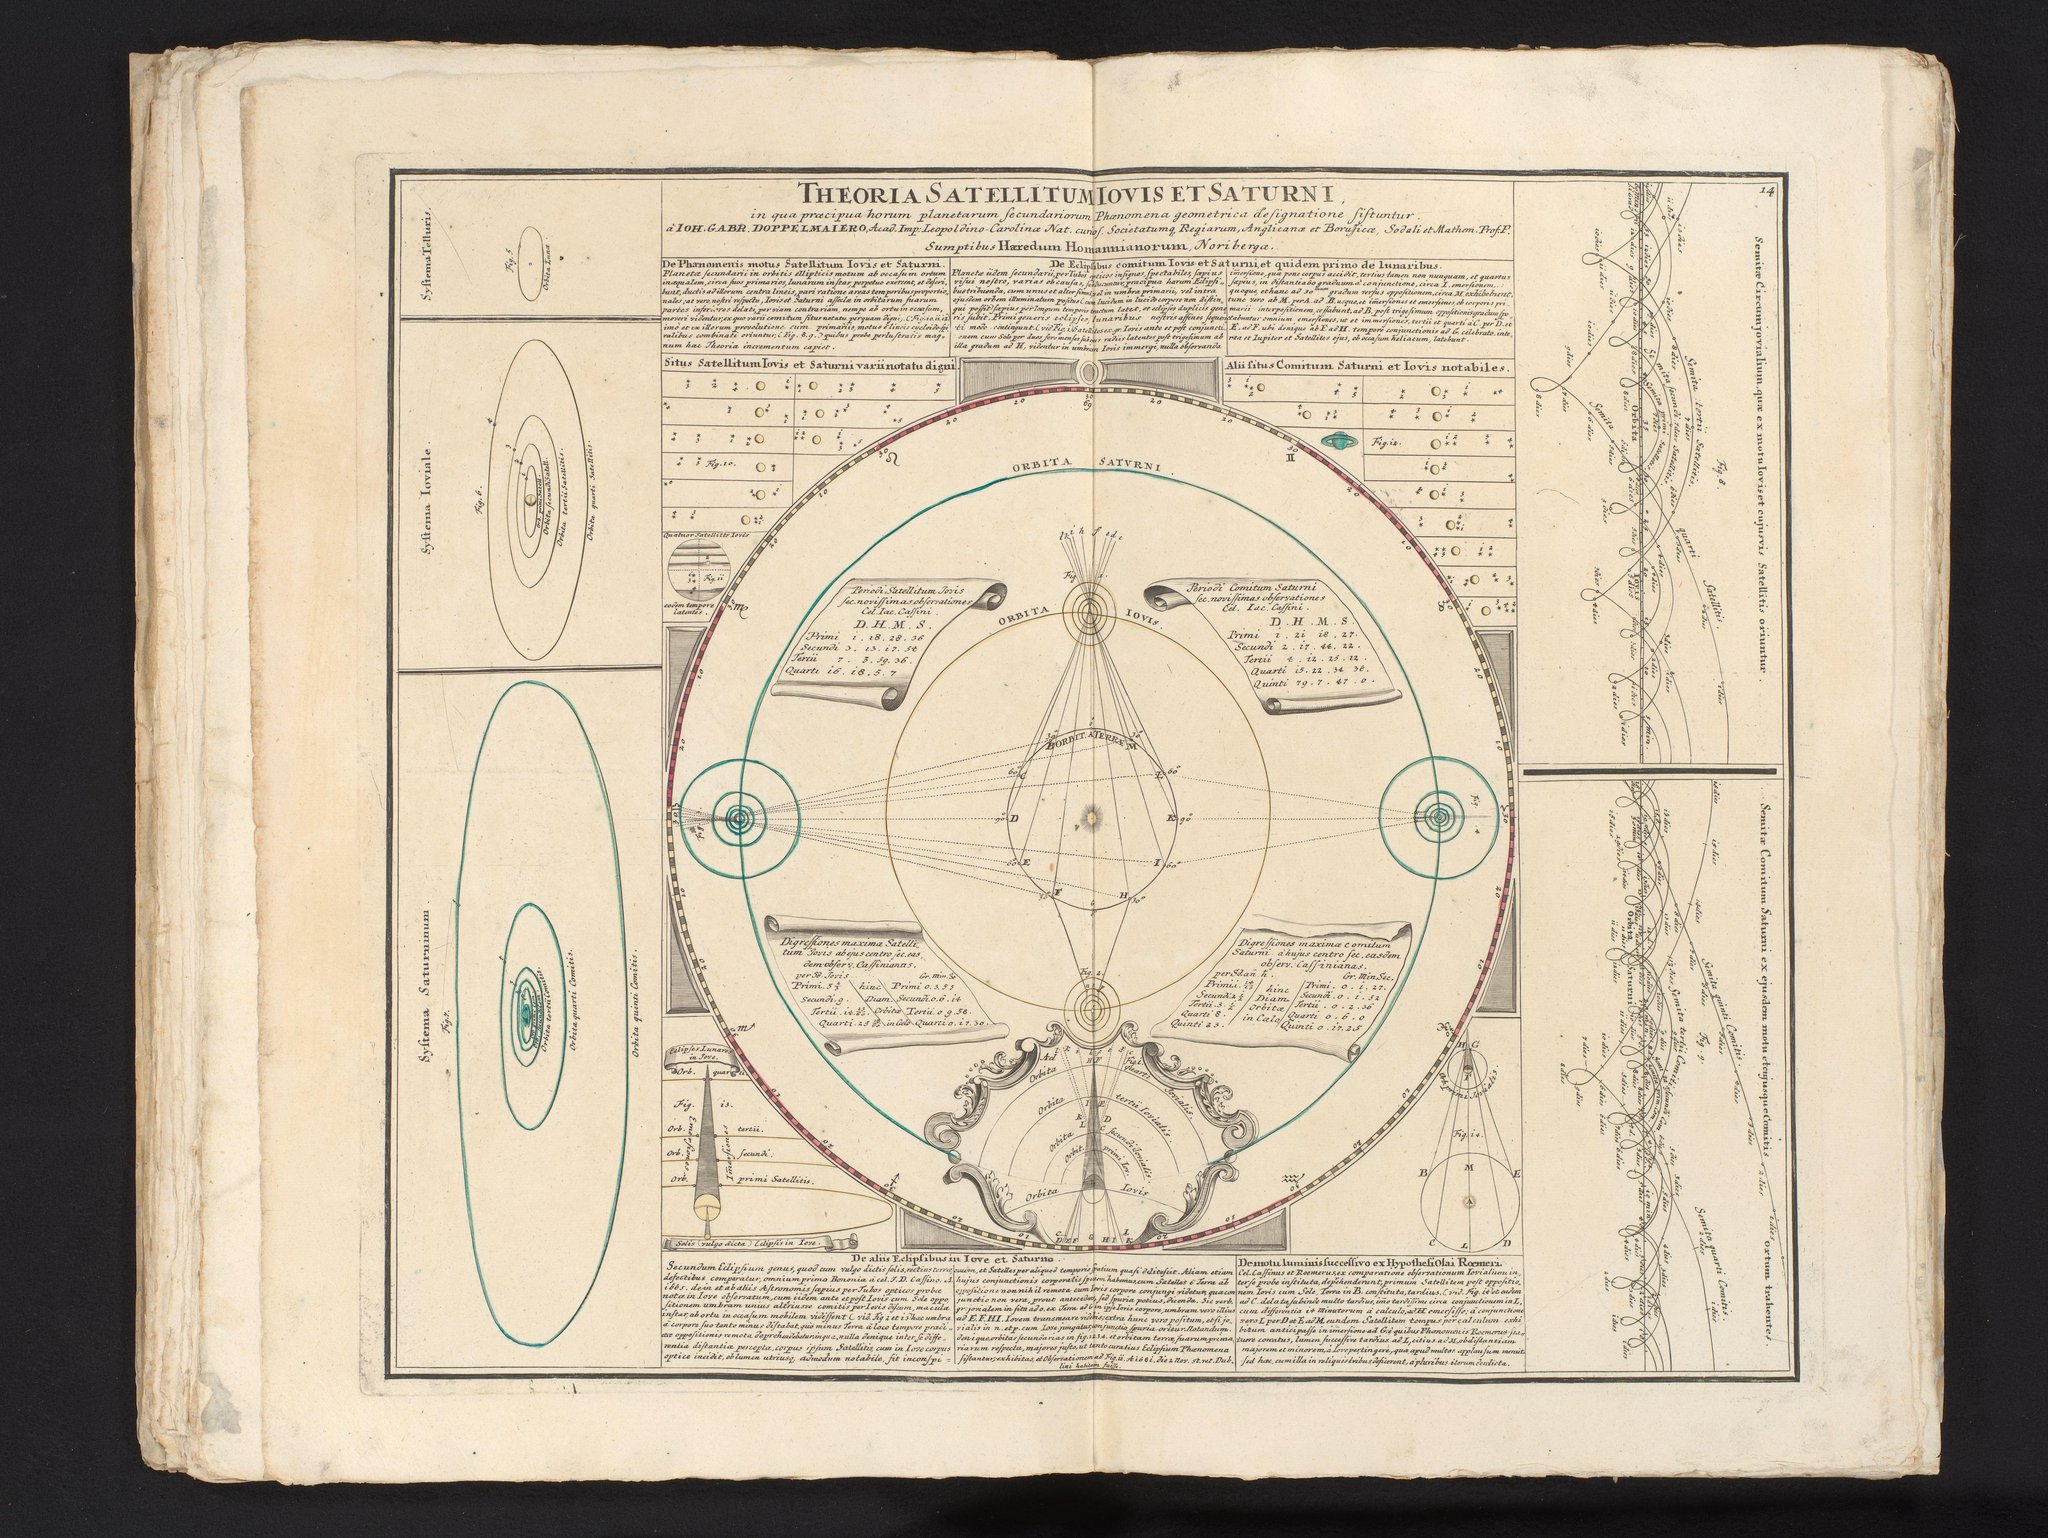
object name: print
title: Hemelkaart van de manen van Jupiter en Saturnus op basis van de observaties van Giovanni Domenico Cassini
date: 1742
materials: paper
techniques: engraving, etching, hand coloring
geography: nuremberg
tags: jupiter (planet), saturn (planet)